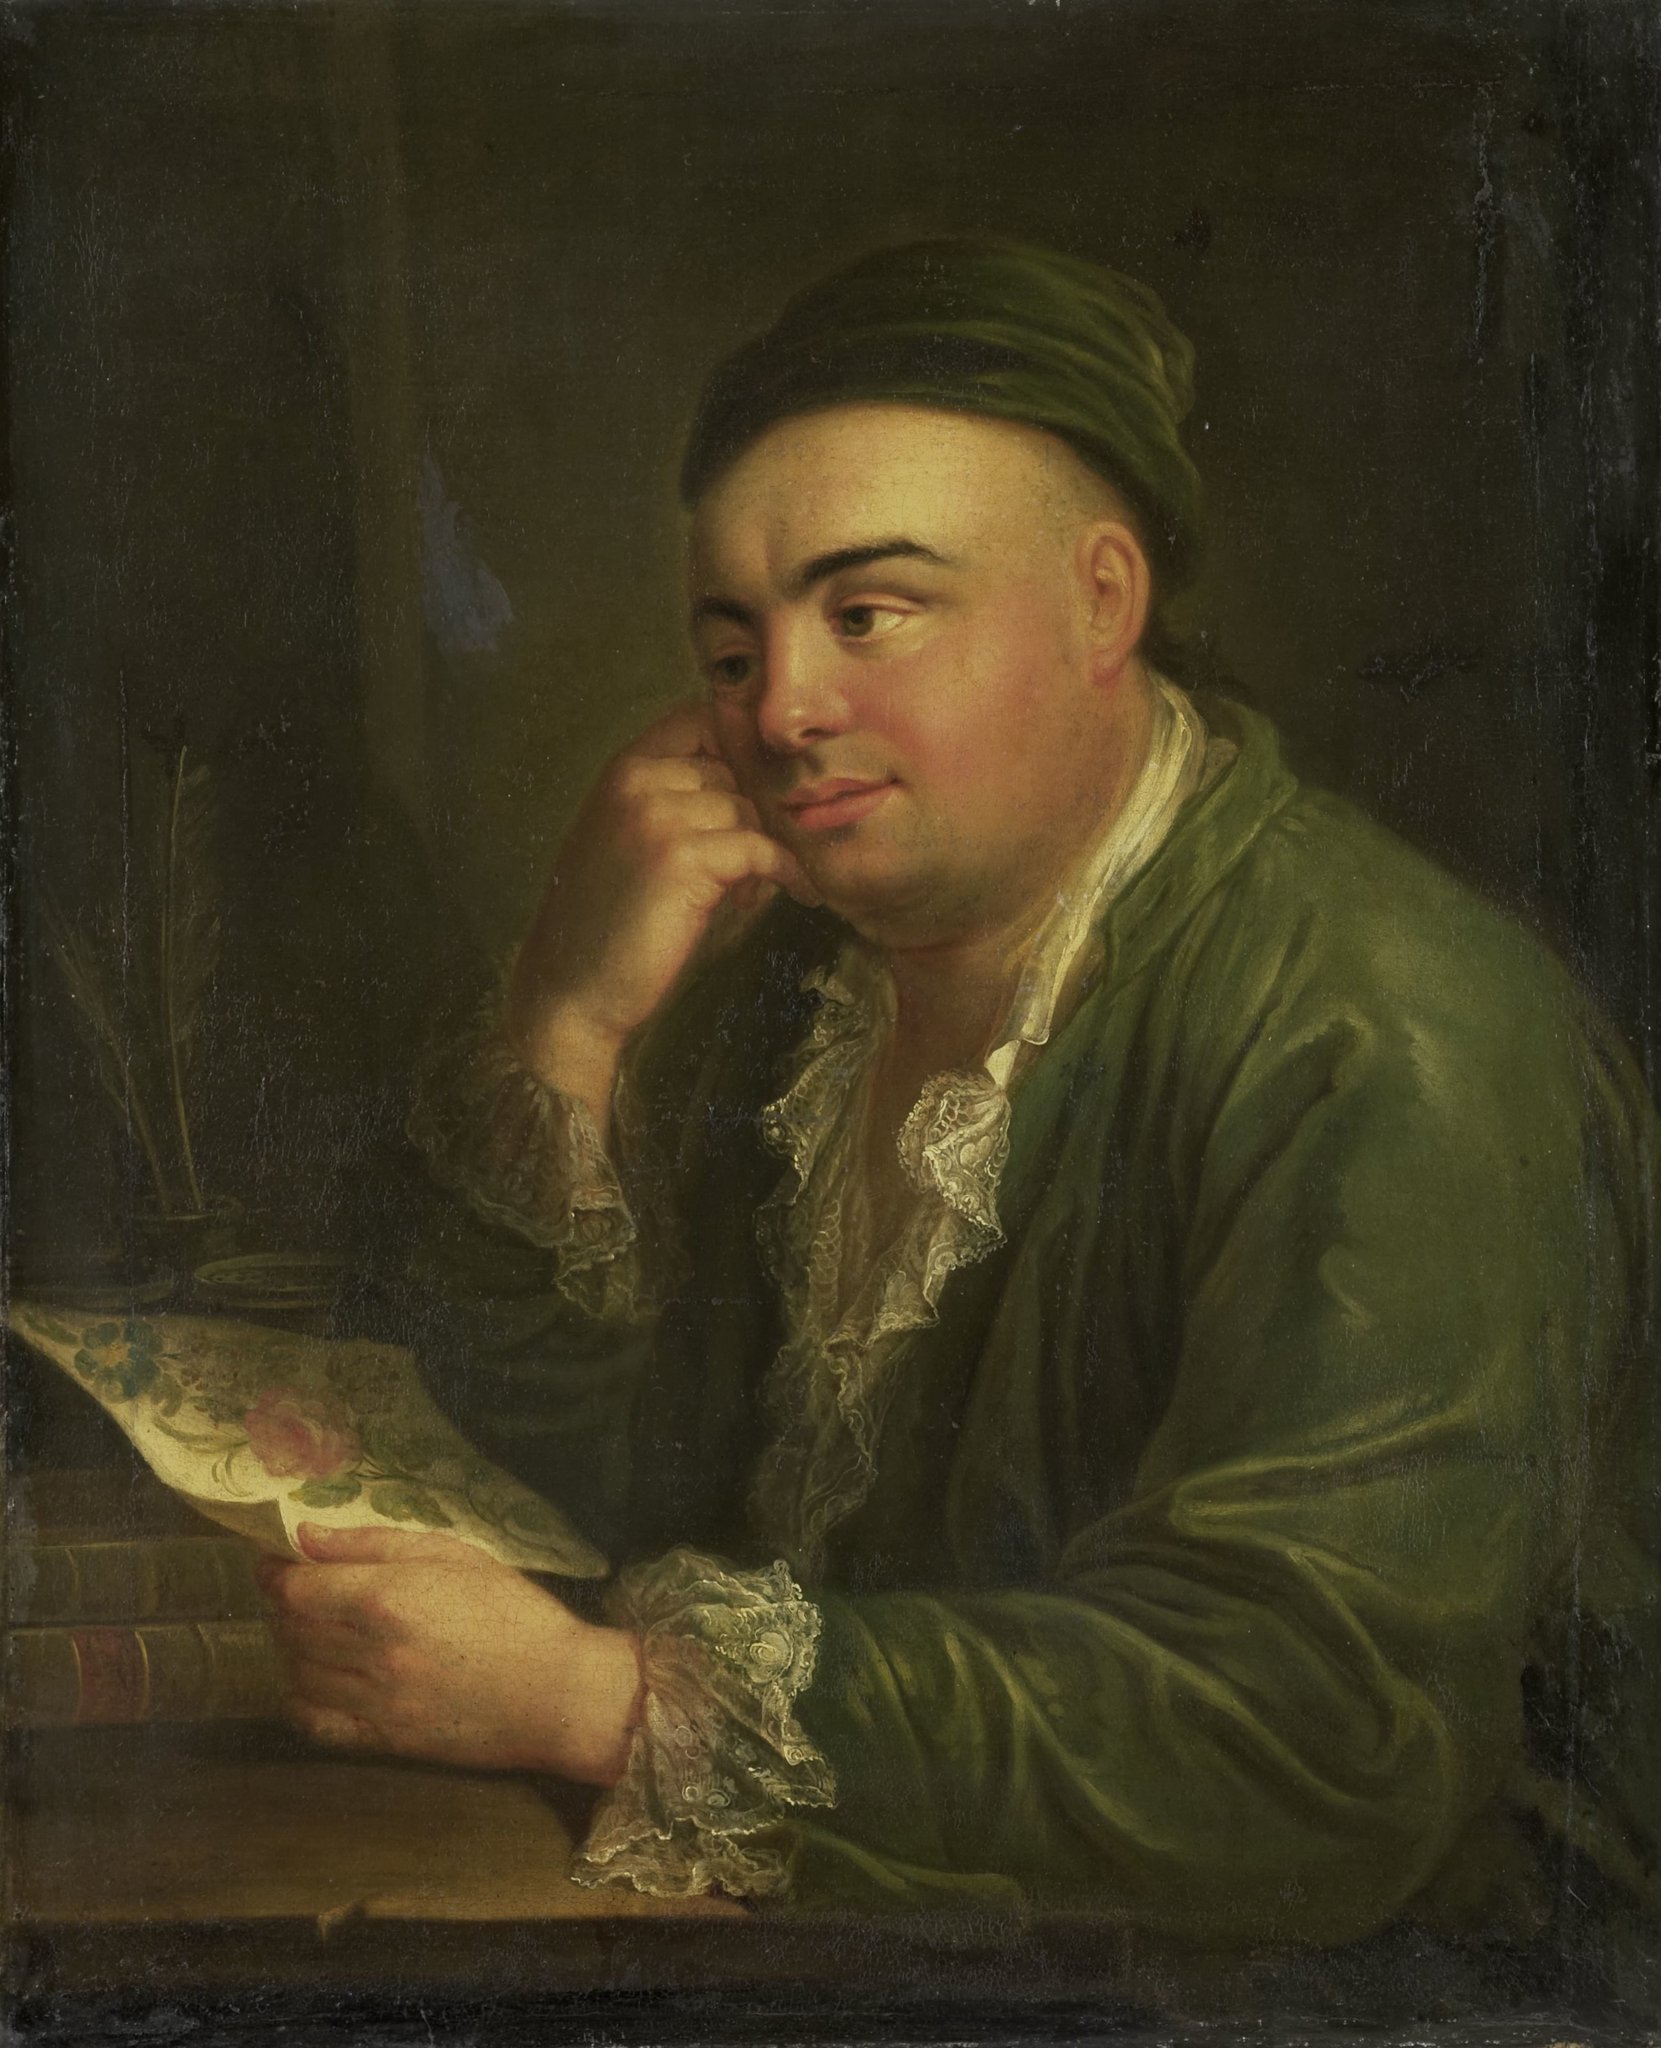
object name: painting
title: A Man with a Drawing of Flowers, so-called Portrait of Jacob Feitama Jr, Merchant in Amsterdam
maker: Anonymous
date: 1730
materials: canvas, oil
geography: netherlands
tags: drawing, sketch, historical persons, anonymous historical person portrayed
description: Portret van een man in een kamerjas, ten halven lijve, zittend aan een tafel met een tekening van bloemen in de hand. Op de tafel staan boeken en een inktstel. Zogenaamd het portret van Jacob Feitama Jr (1698-1774), koopman te Amsterdam. Pendant van het portret van zijn echtgenote (1727) Susanna van Collen SK-A-3220.